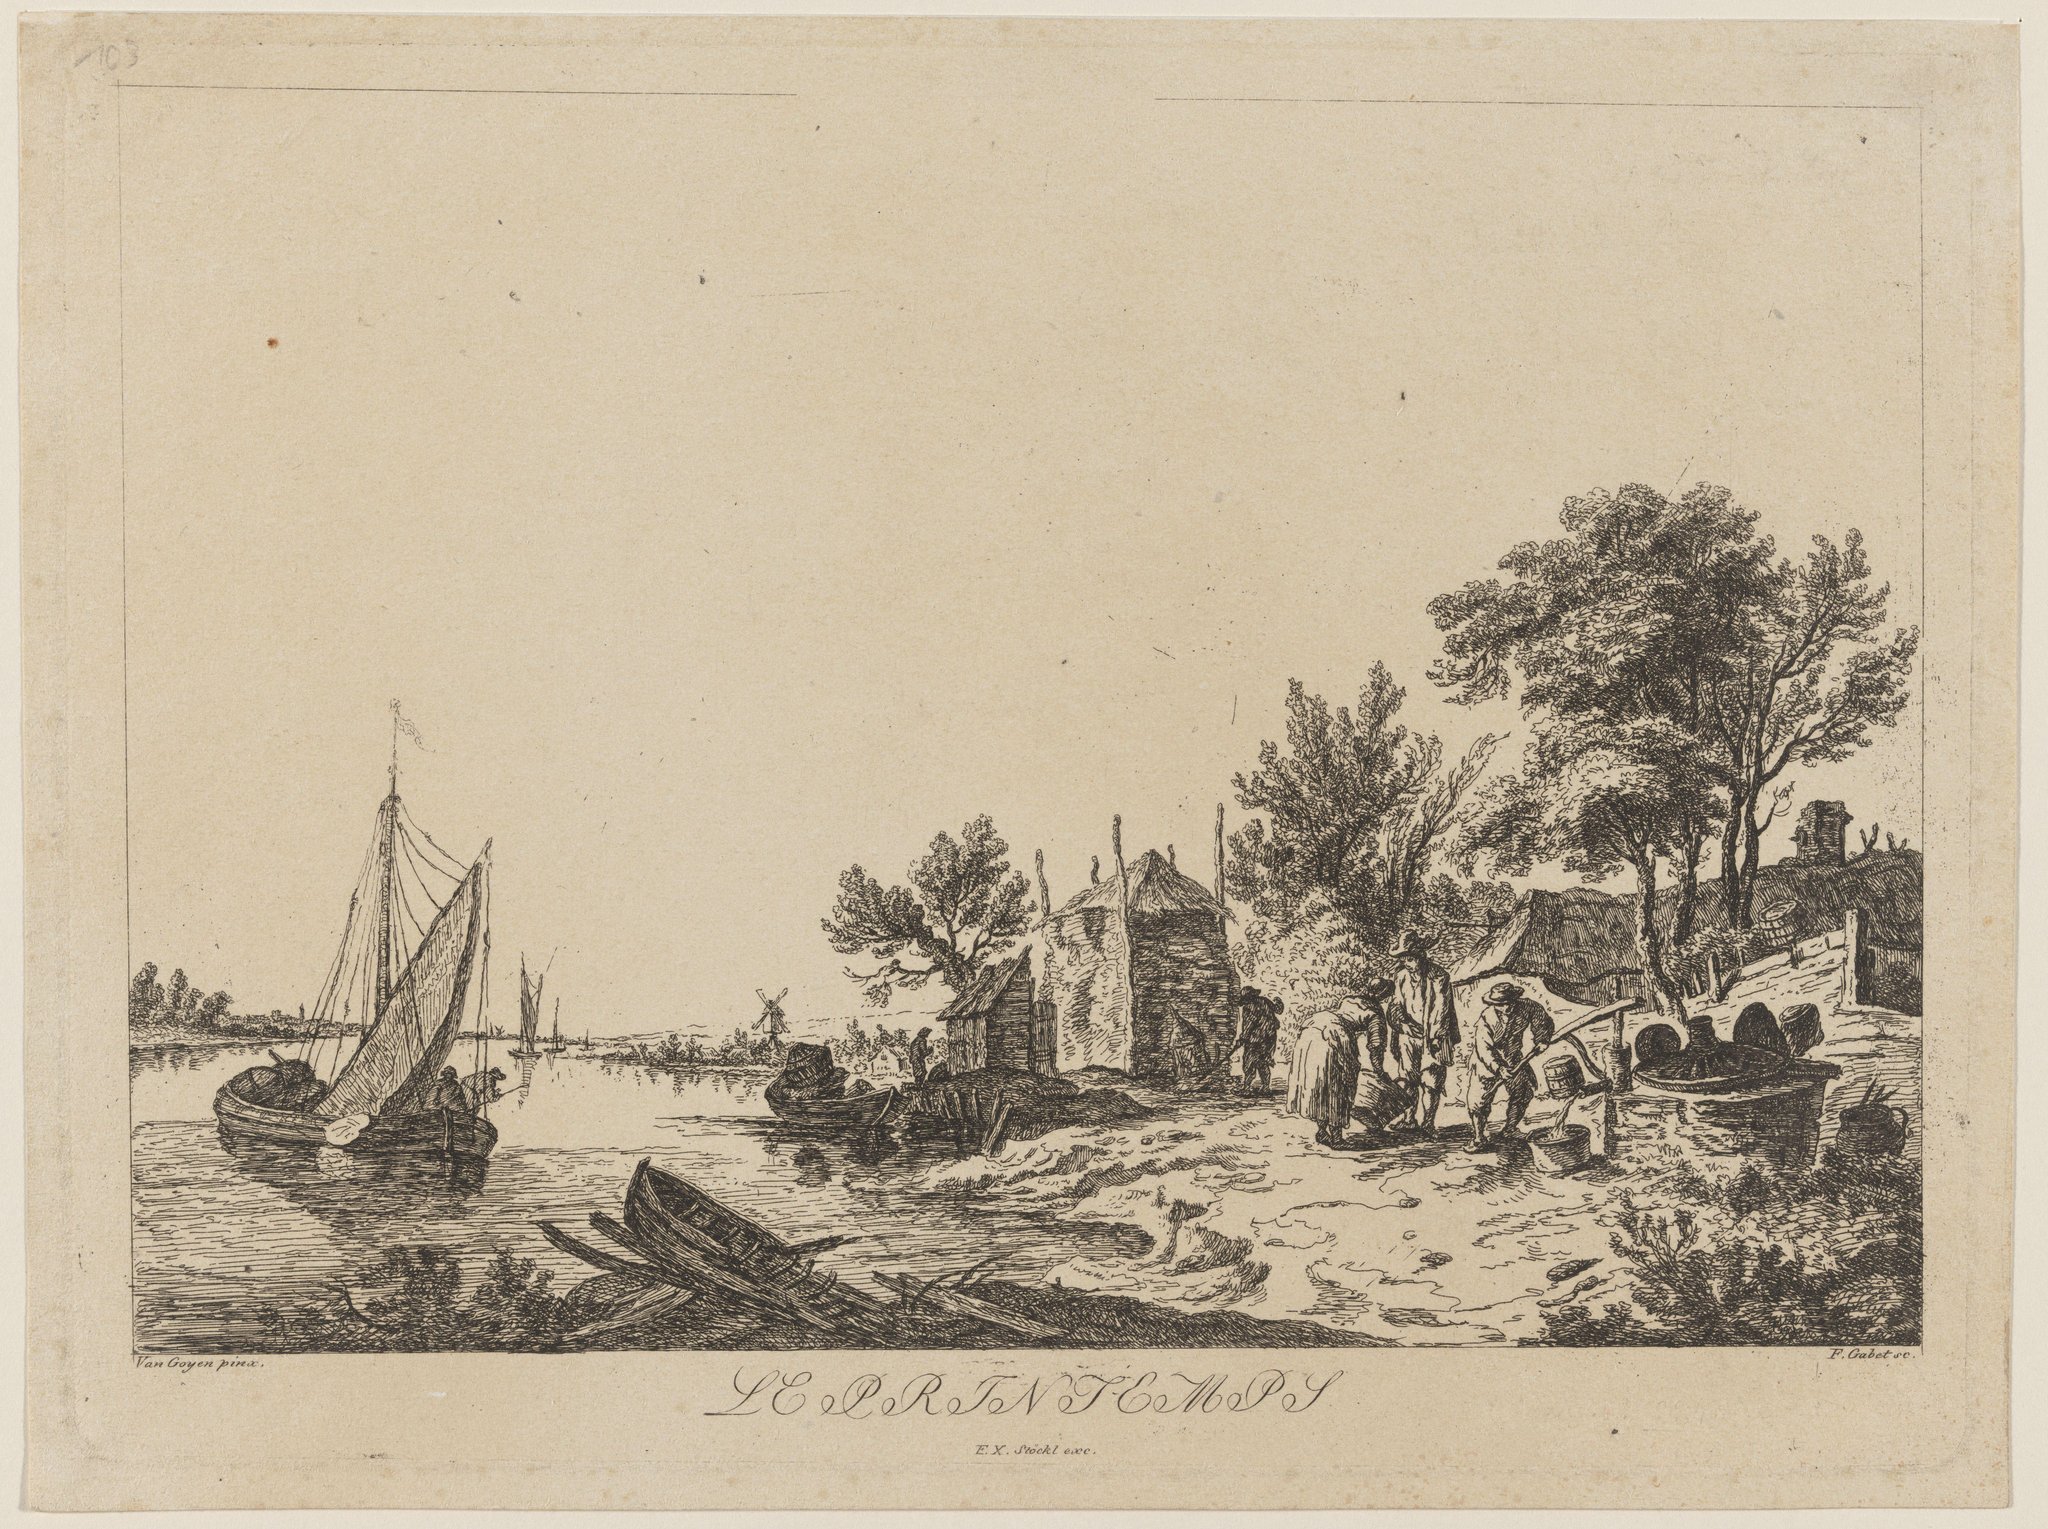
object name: print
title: De vier seizoen naar schilderijen van Jan van Goyen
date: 1790-1820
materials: paper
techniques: etching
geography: netherlands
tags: pump, river (+ landscape with figures, staffage), farm (building)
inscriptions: collector's mark: Lugt 2827, collector's mark: Lugt 2228, collector's mark: Lugt 2760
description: Rivierlandschap met links een zeilschuit op het water. Rechts verschillende figuren bij een boerderij met hooischuur, een man pompt water met de pomp. Prent uit een serie van de vier seizoenen.